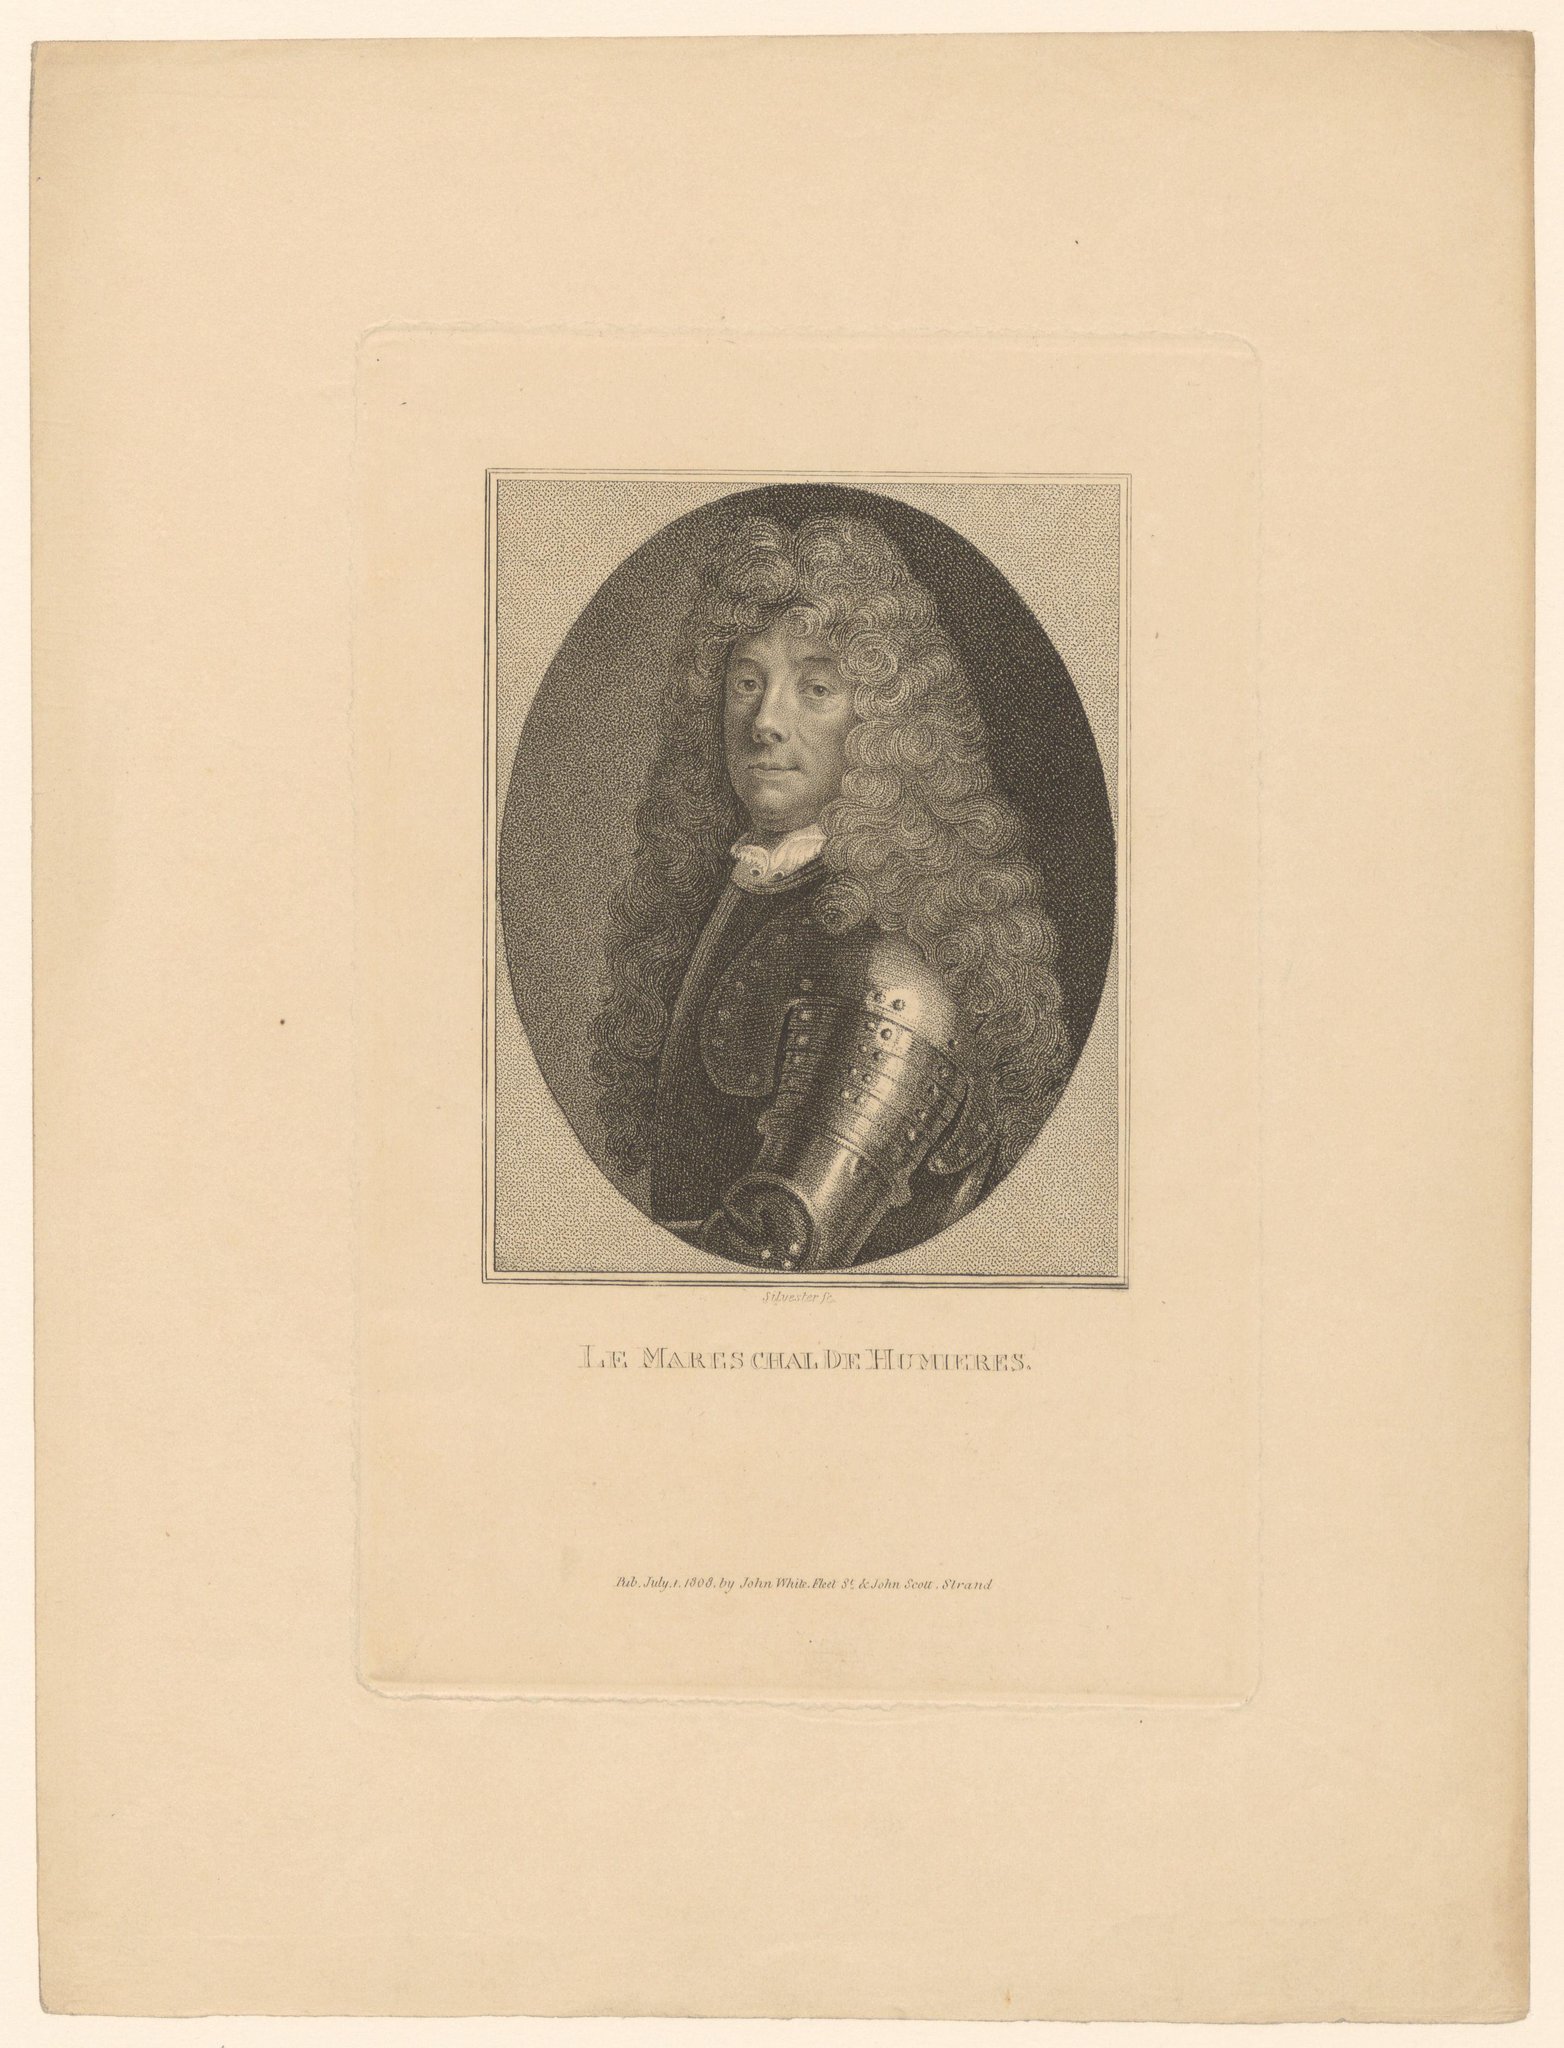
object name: print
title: Portret van Louis de Crévant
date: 1807-1808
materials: paper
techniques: engraving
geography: london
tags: louis de crévant (hertog van humières), commander-in-chief, general, marshal, historical persons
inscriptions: collector's mark: Lugt 2228